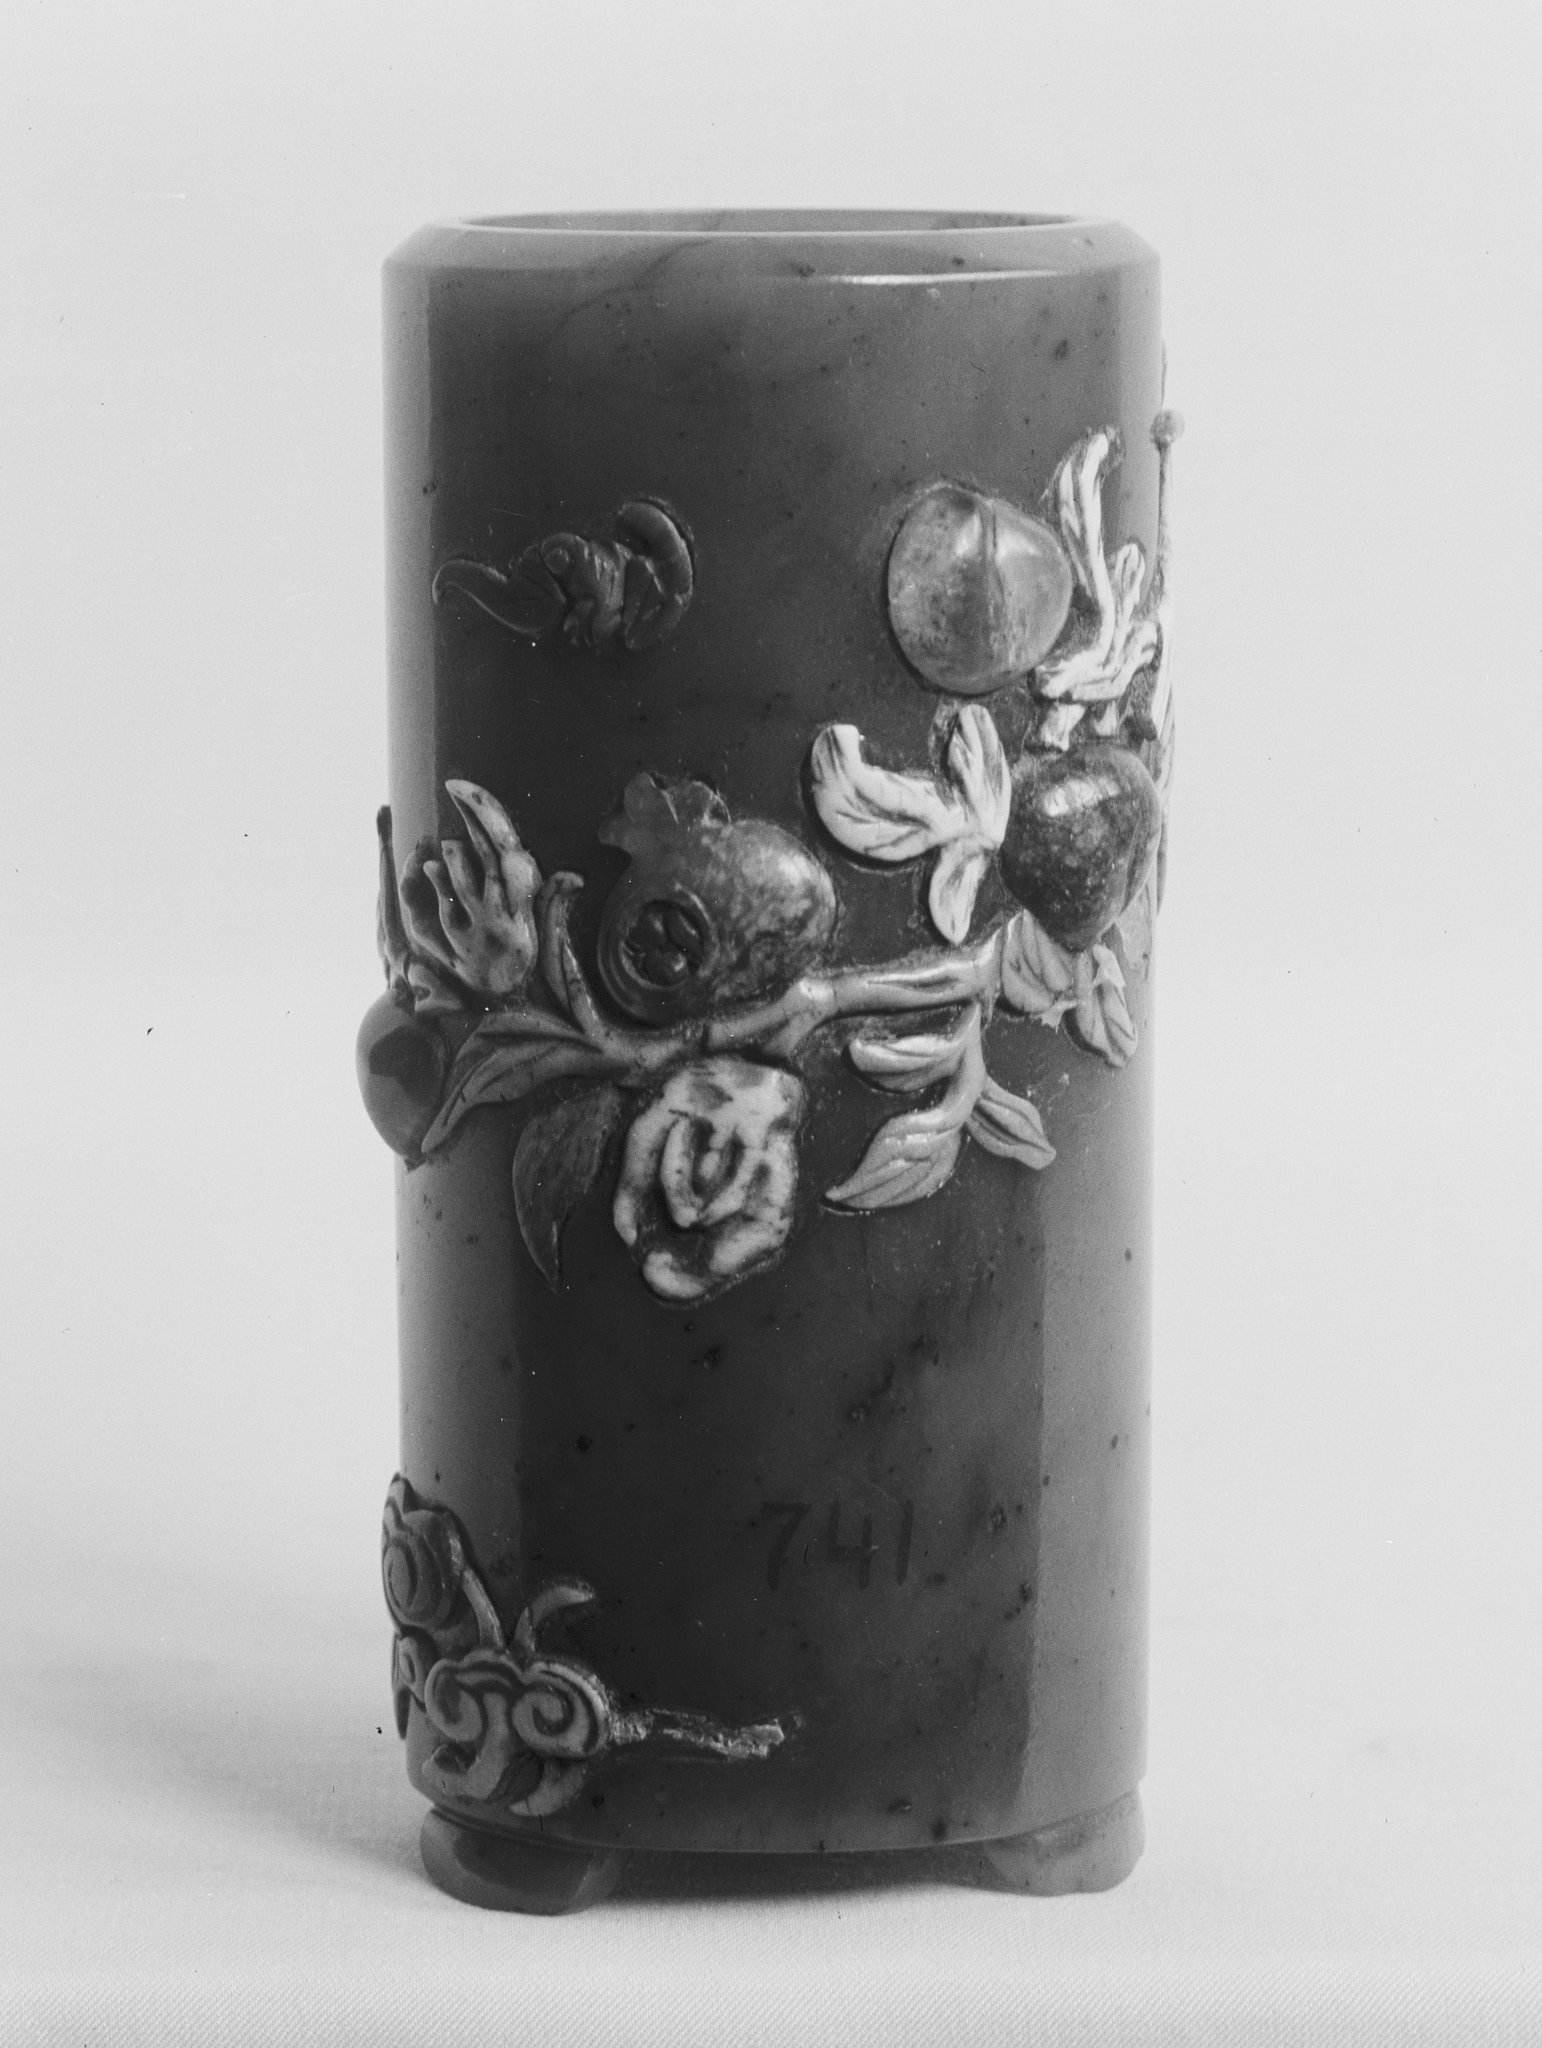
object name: brush holder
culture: chinese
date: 1736-1795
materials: jade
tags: flowers